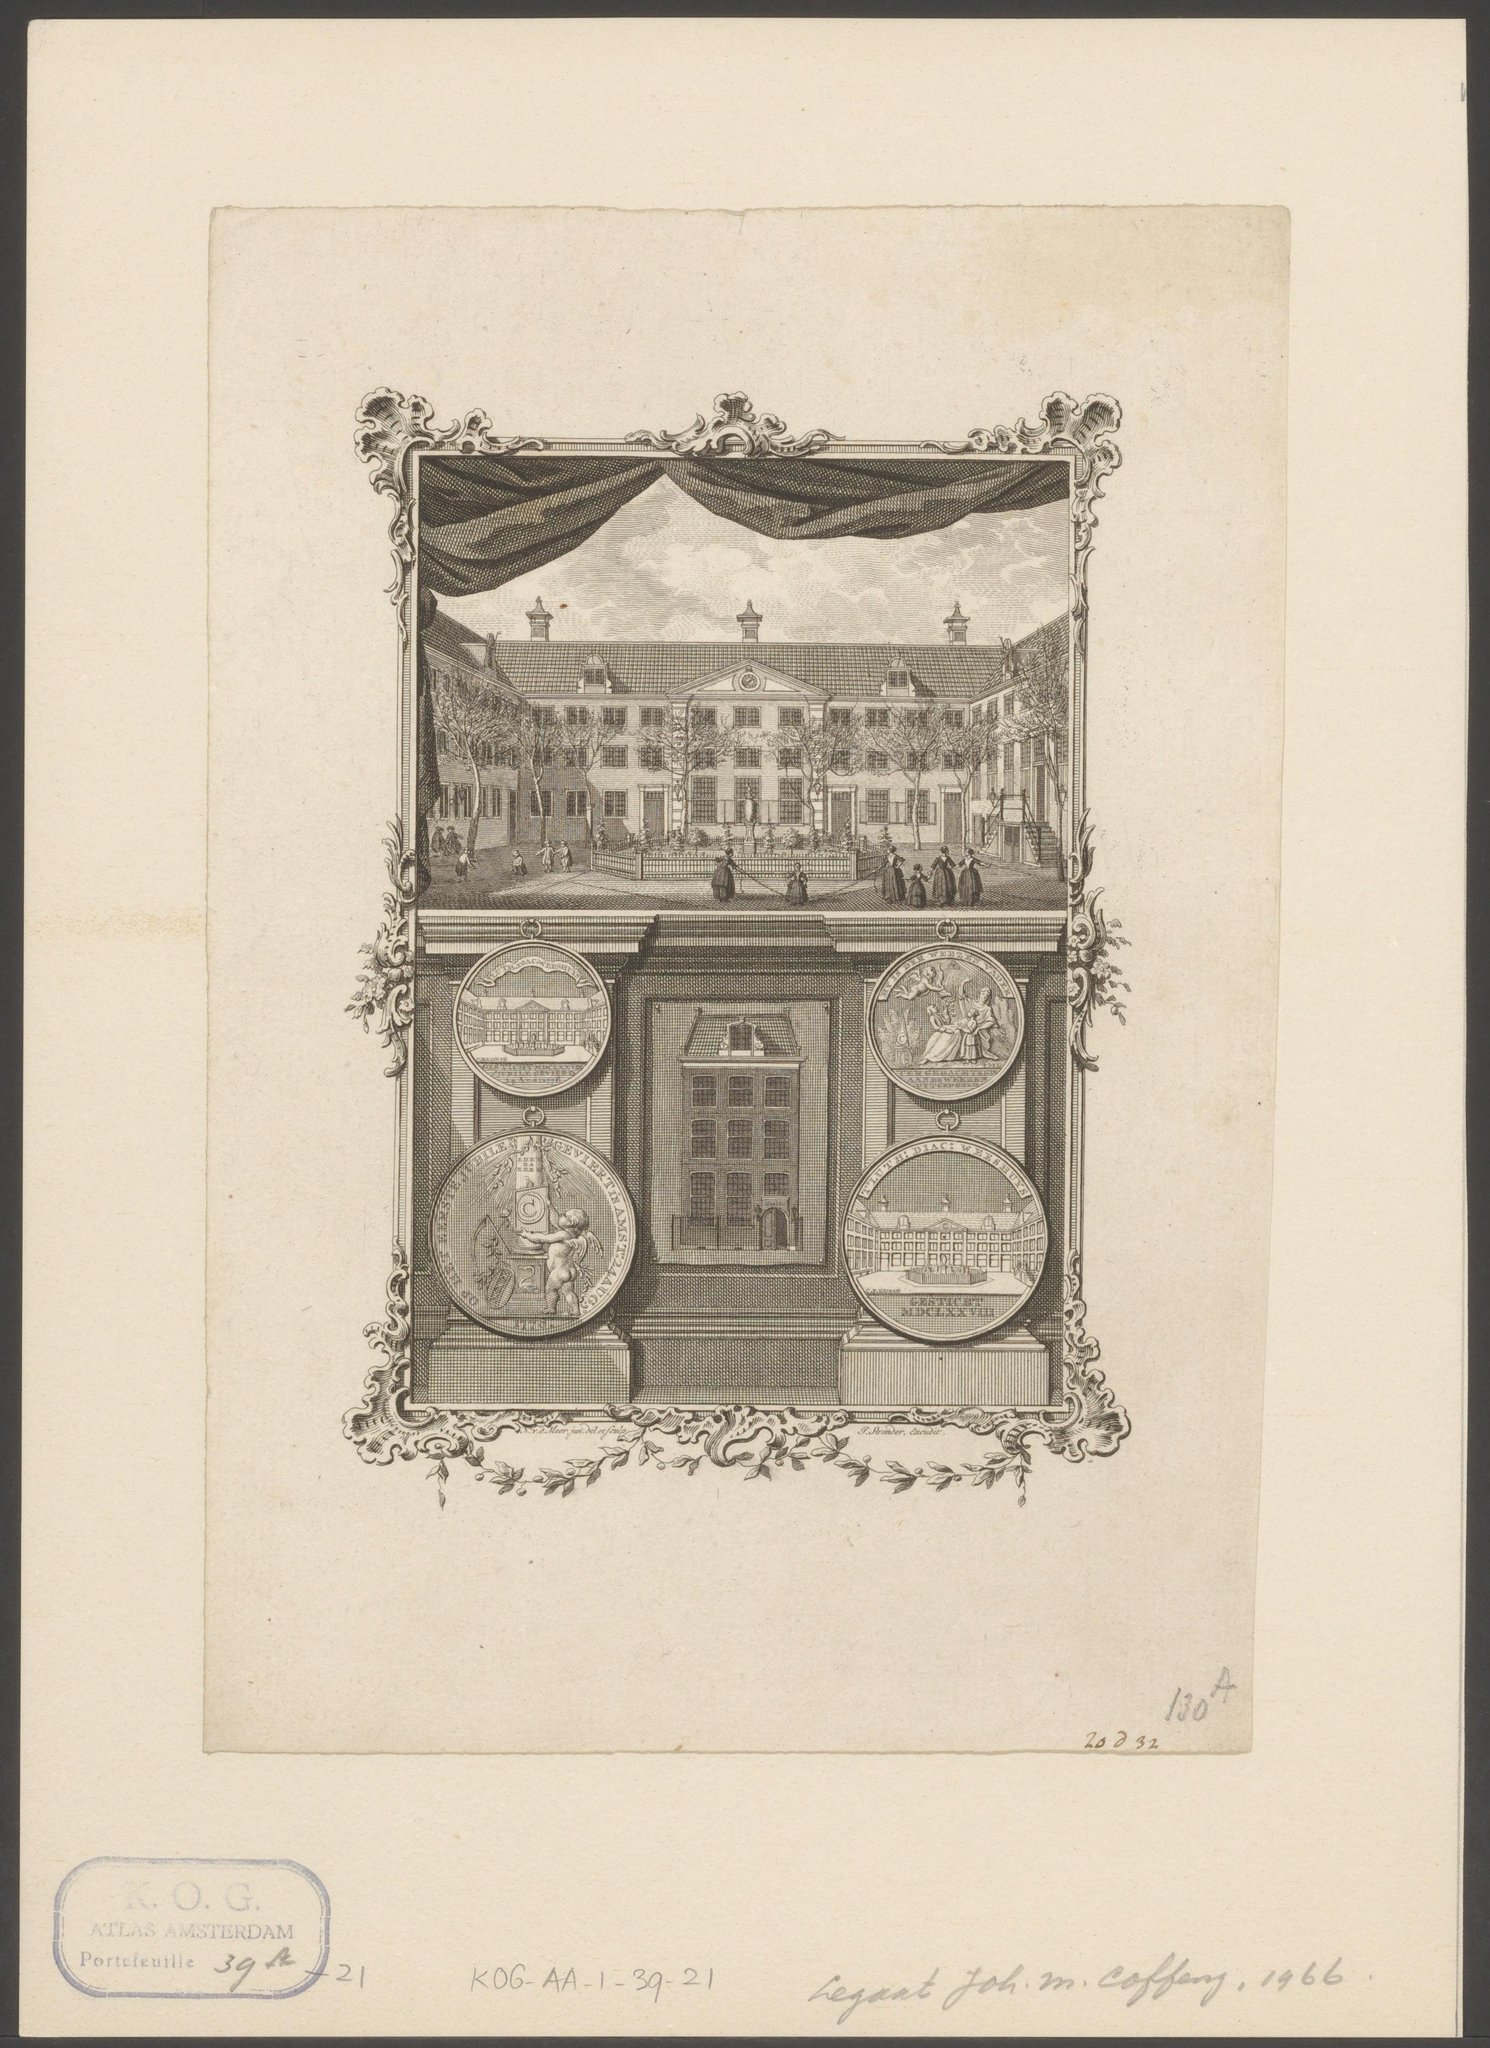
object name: print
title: Gezicht op de binnenplaats van het Lutherse Diaconieweeshuis te Amsterdam en penningen voor het eerste eeuwfeest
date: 1778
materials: paper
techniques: engraving, etching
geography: amsterdam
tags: medal (considered as a piece of sculpture, regardless of its specific function), courtyard, orphanage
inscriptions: collector's mark: Lugt 1641b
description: Prent mogelijk uit: Vorstius, Jan Hendrik. Redevoering op het eerste eeuwfeest van het Luthersche Diakonie-weeshuis binnen Amsterdam (...). Amsterdam: Johannes Strander (II), 1778.